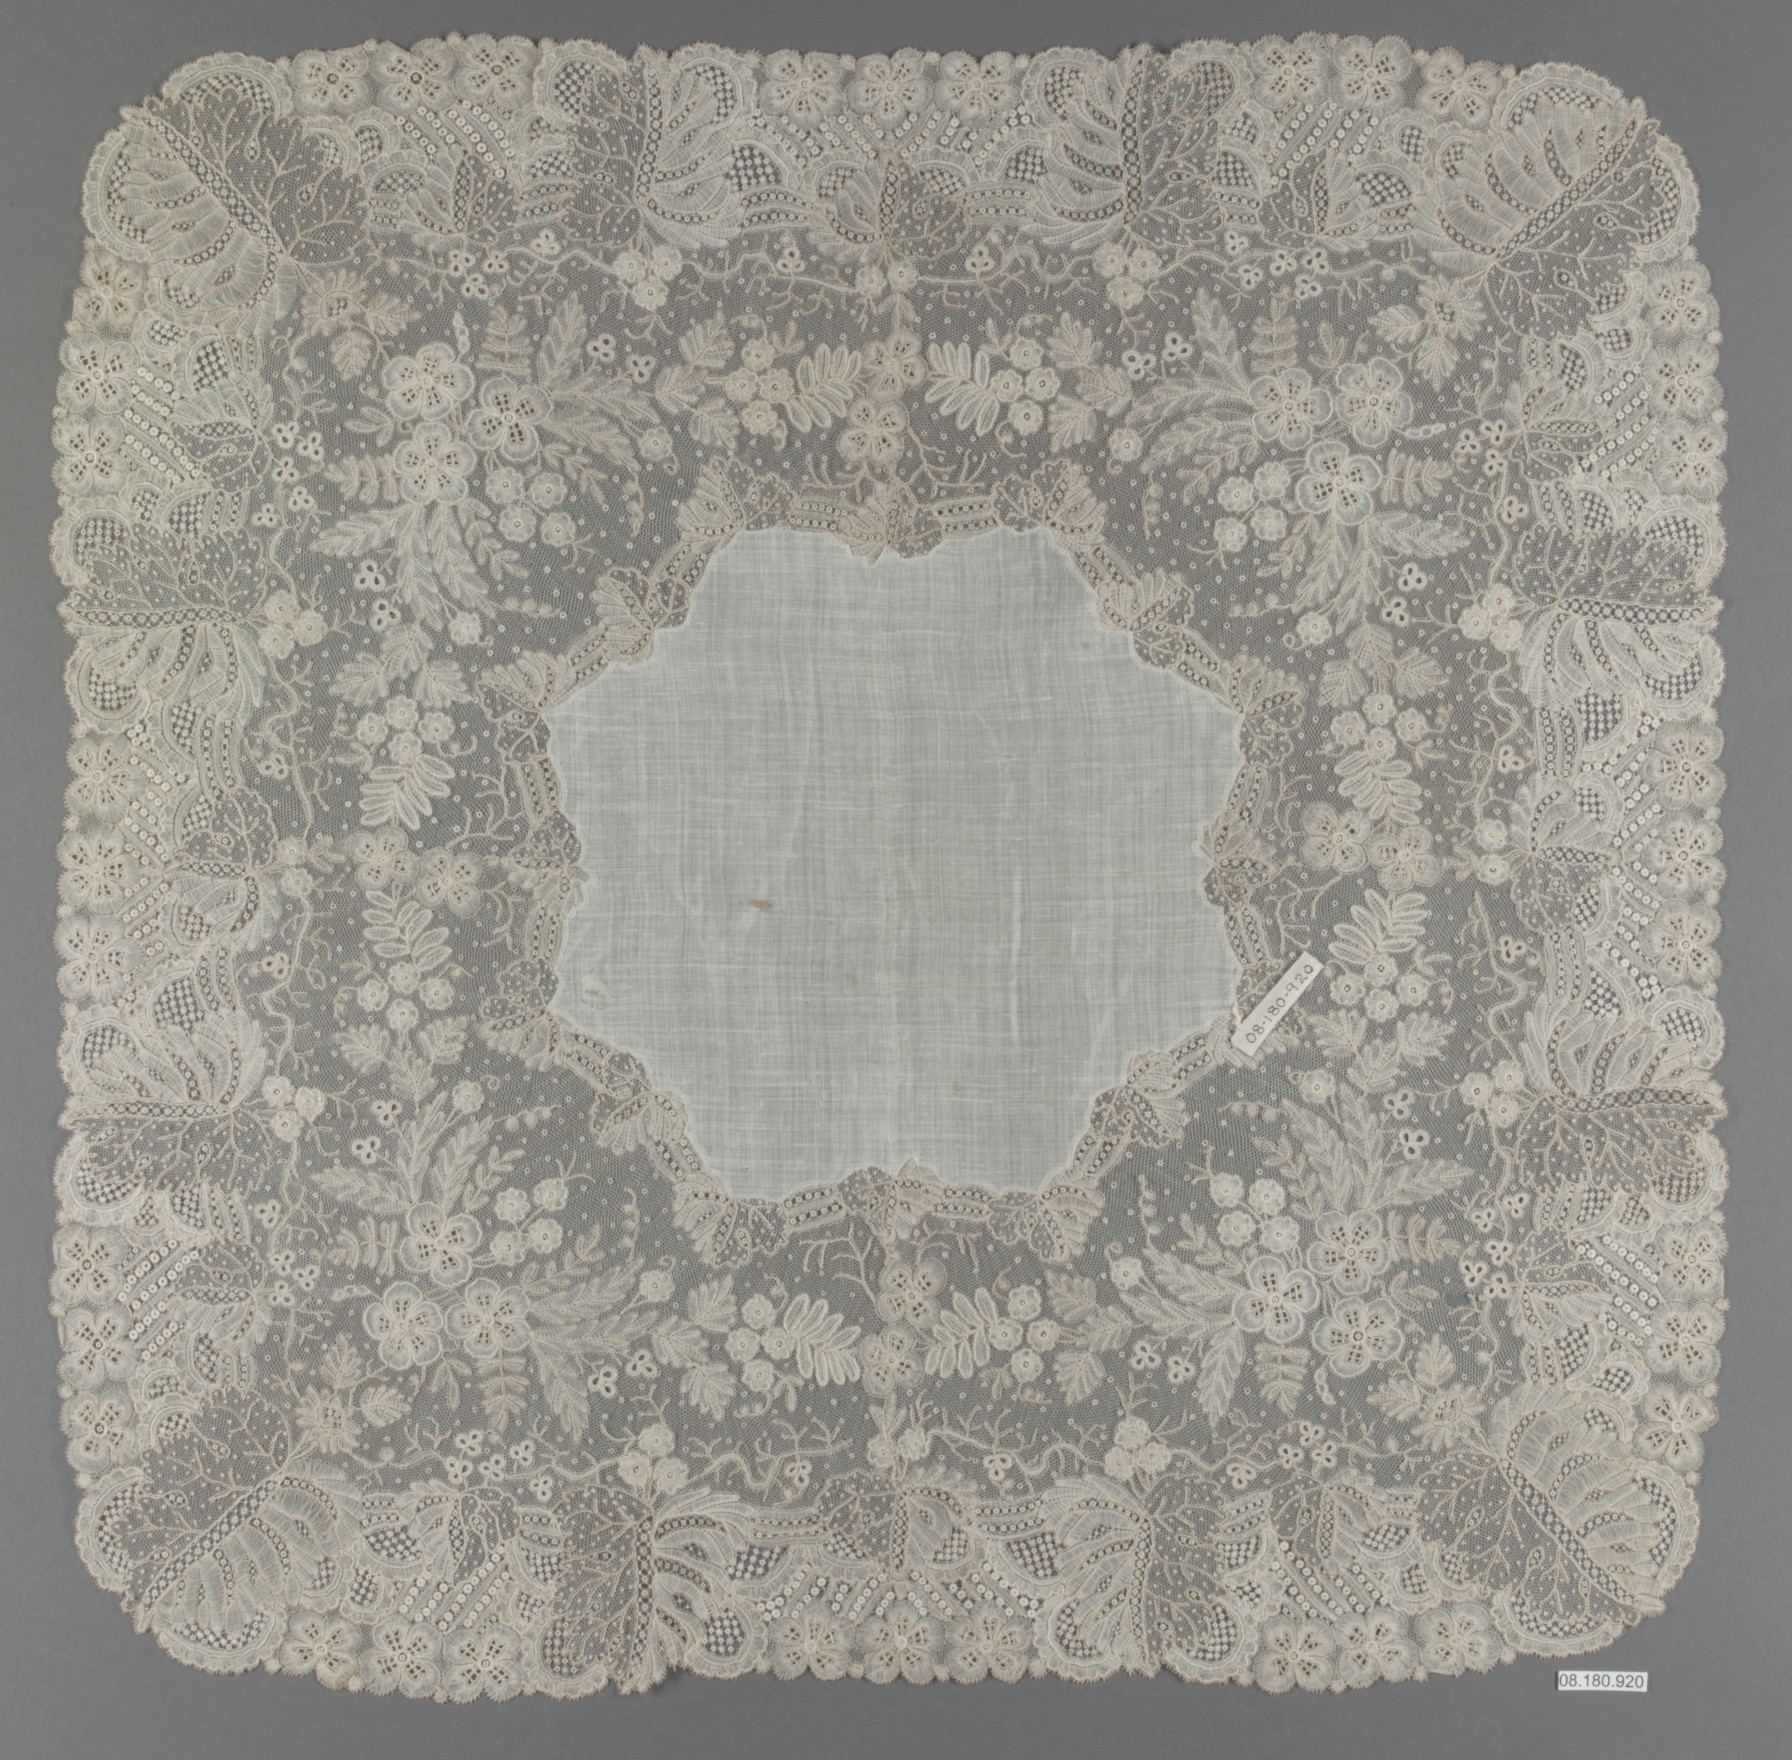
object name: handkerchief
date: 1801-1900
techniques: lace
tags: flowers